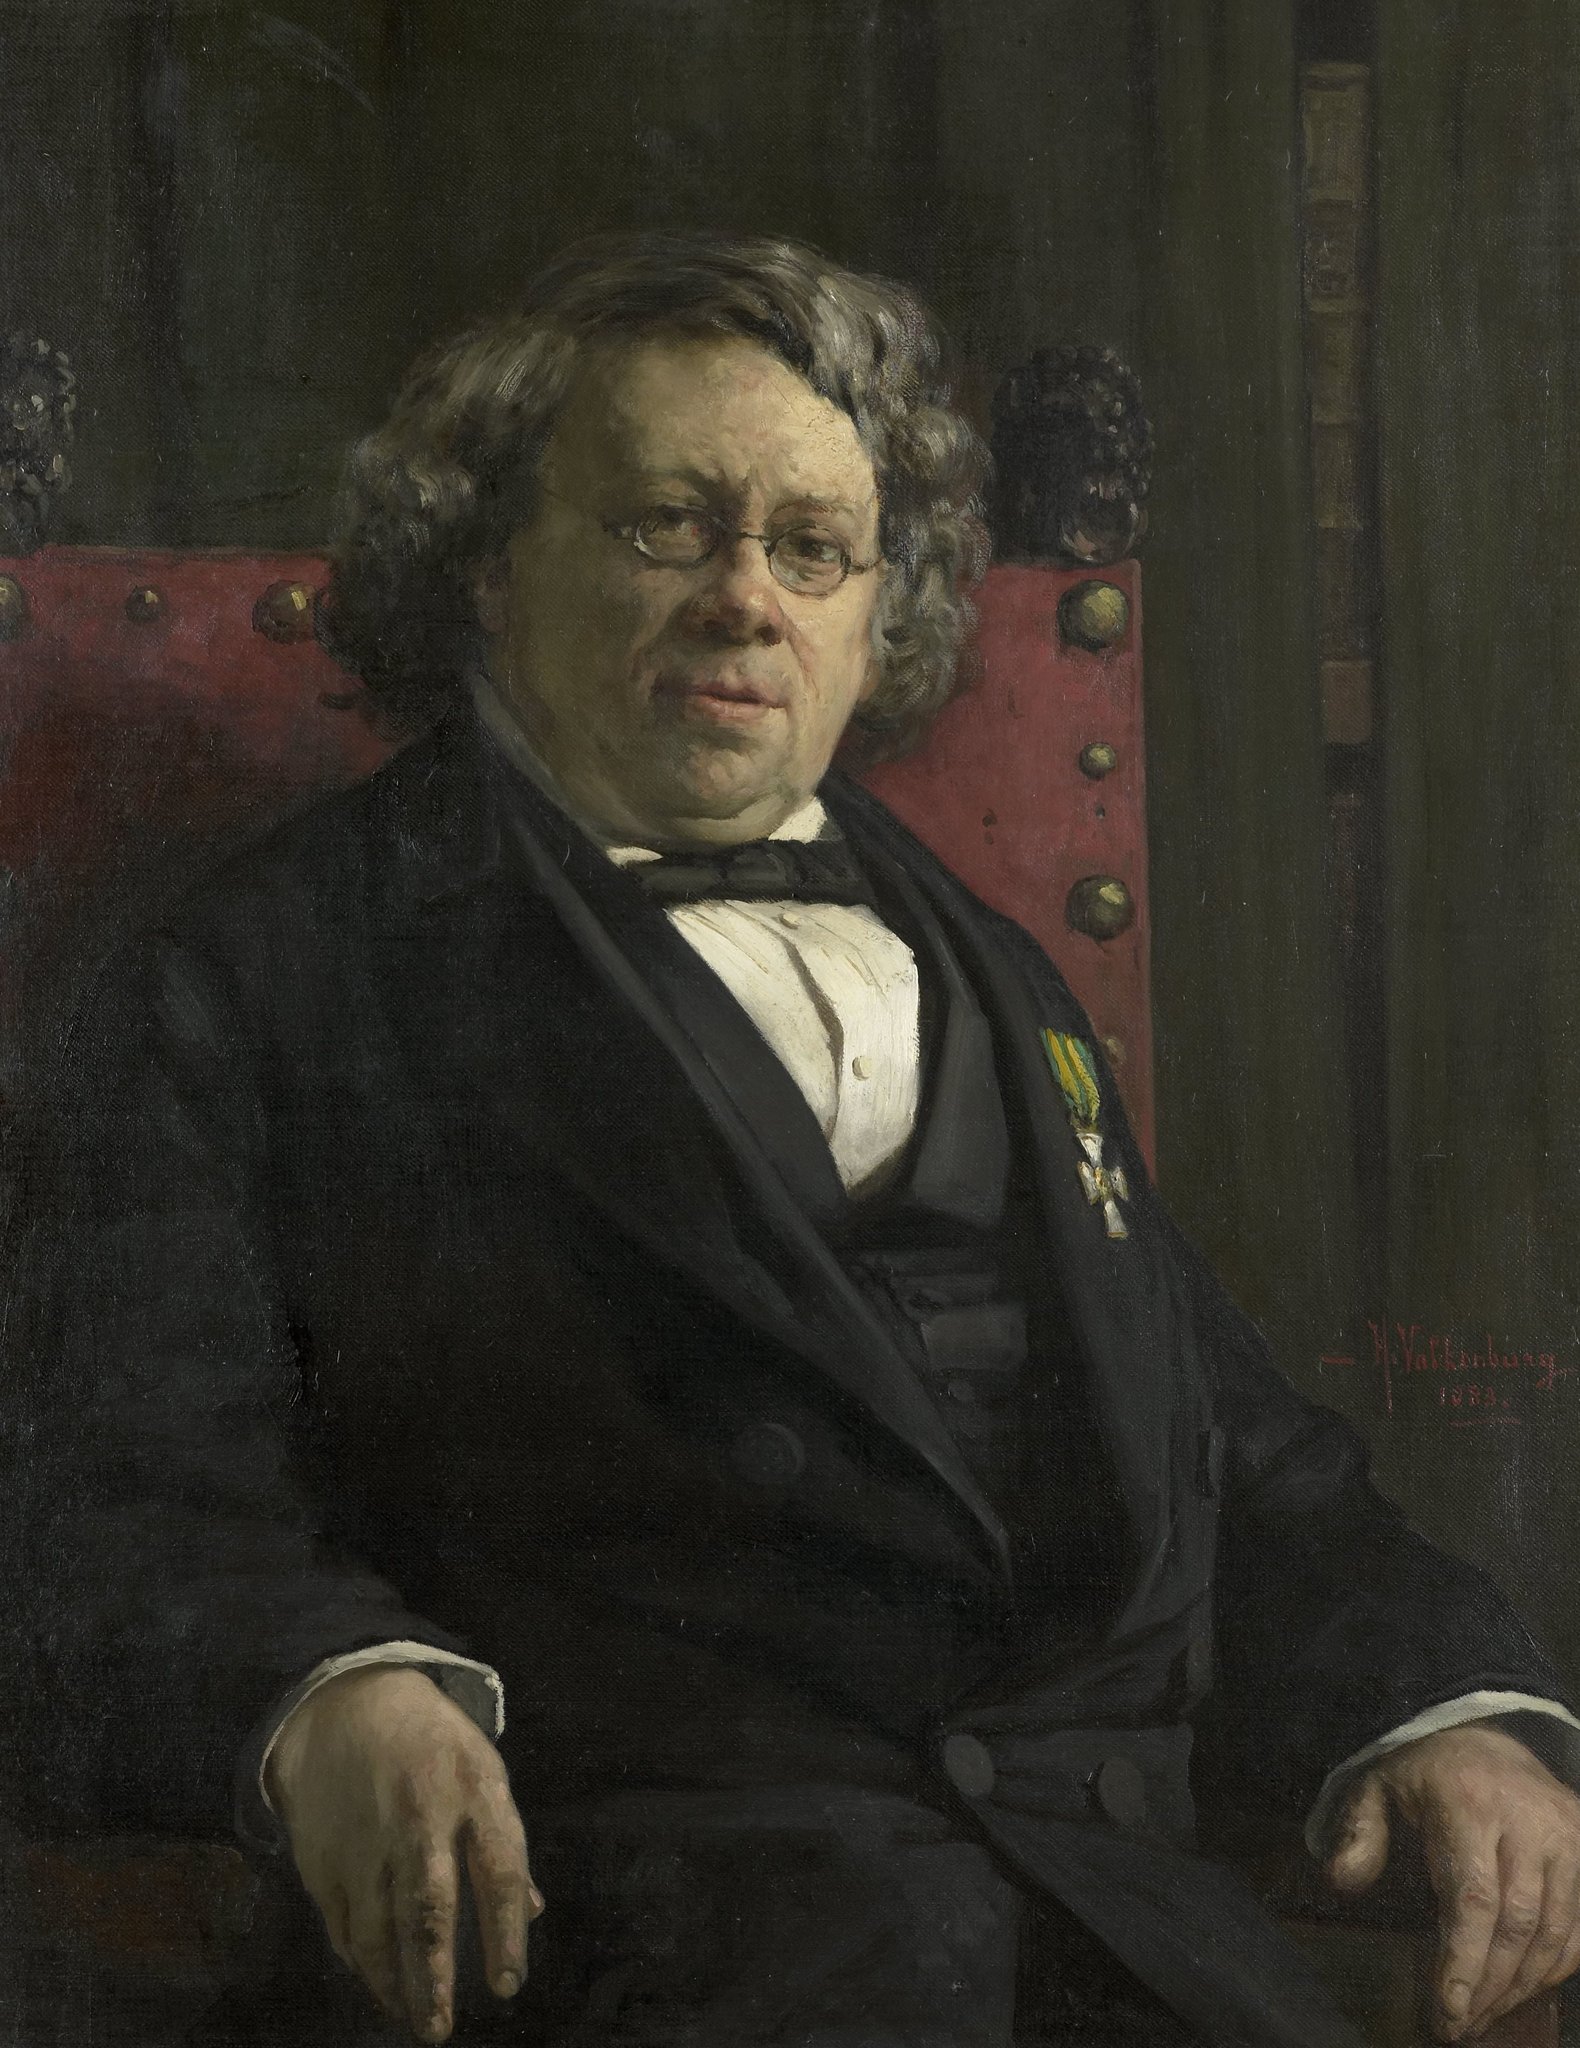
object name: painting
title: Pieter Harme Witkamp (1816-92). Geschiedschrijver en aardrijkskundige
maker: hendrik valkenburg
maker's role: draughtsman, painter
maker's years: 1826-1896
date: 1883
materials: canvas, oil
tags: historical persons, historical disciplines; philology (+ portrait of scholar, scientist), geography (+ portrait of scholar, scientist)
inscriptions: signature and date: ‘H. Valkenburg. 1883’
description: Portret van Pieter Harme Witkamp (1816-92), geschiedschrijver en aardrijkskundige. Ten halven lijve, zittend in een stoel.